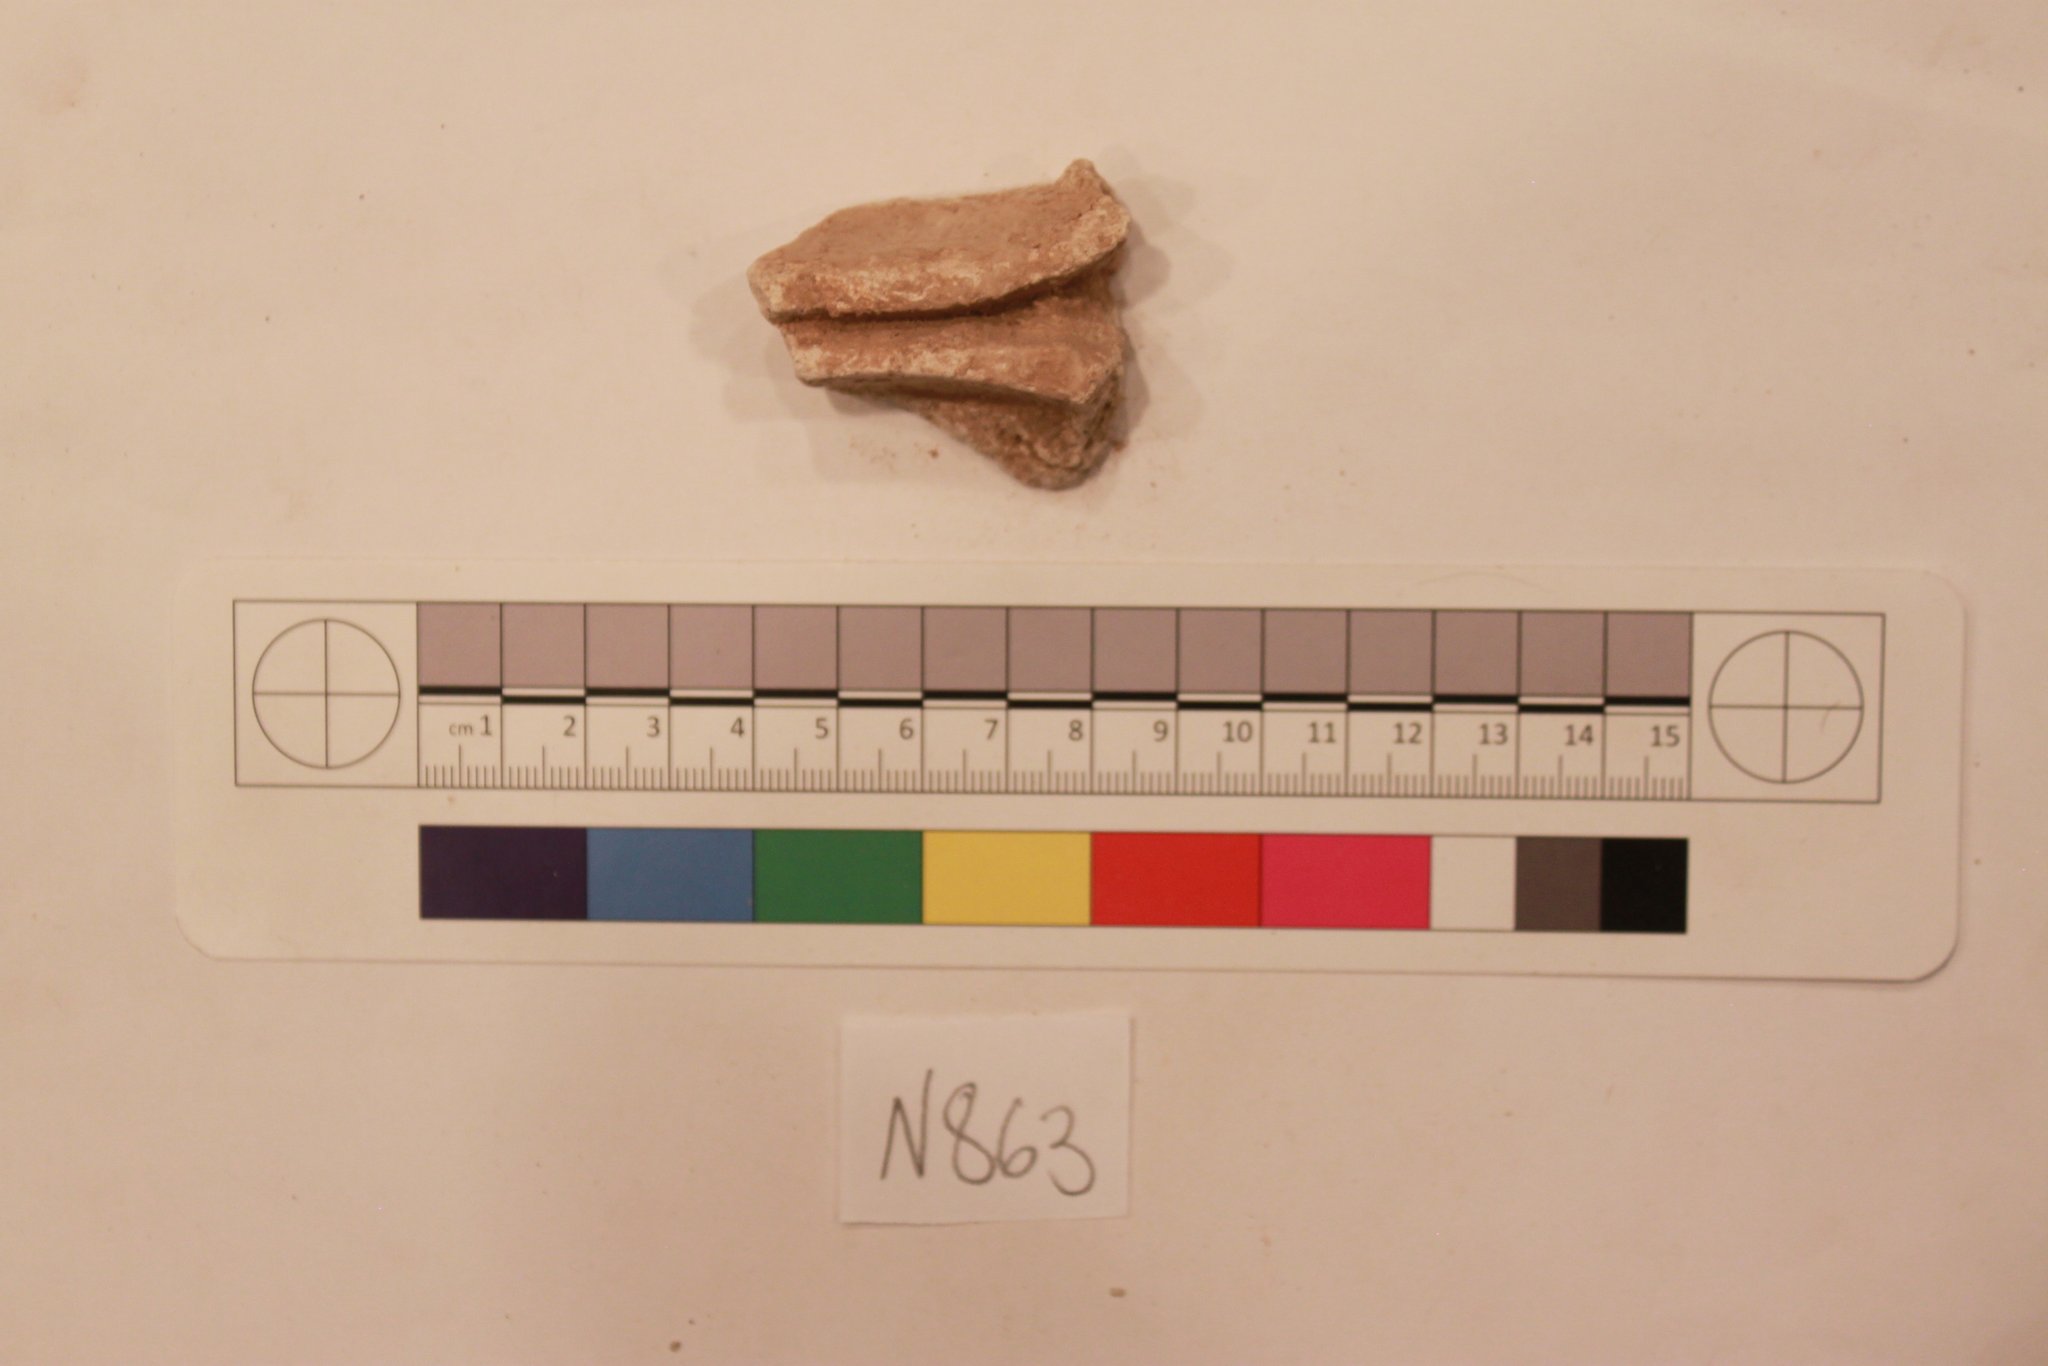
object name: fragment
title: Stucco Fragment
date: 701-1200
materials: plaster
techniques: carving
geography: iran